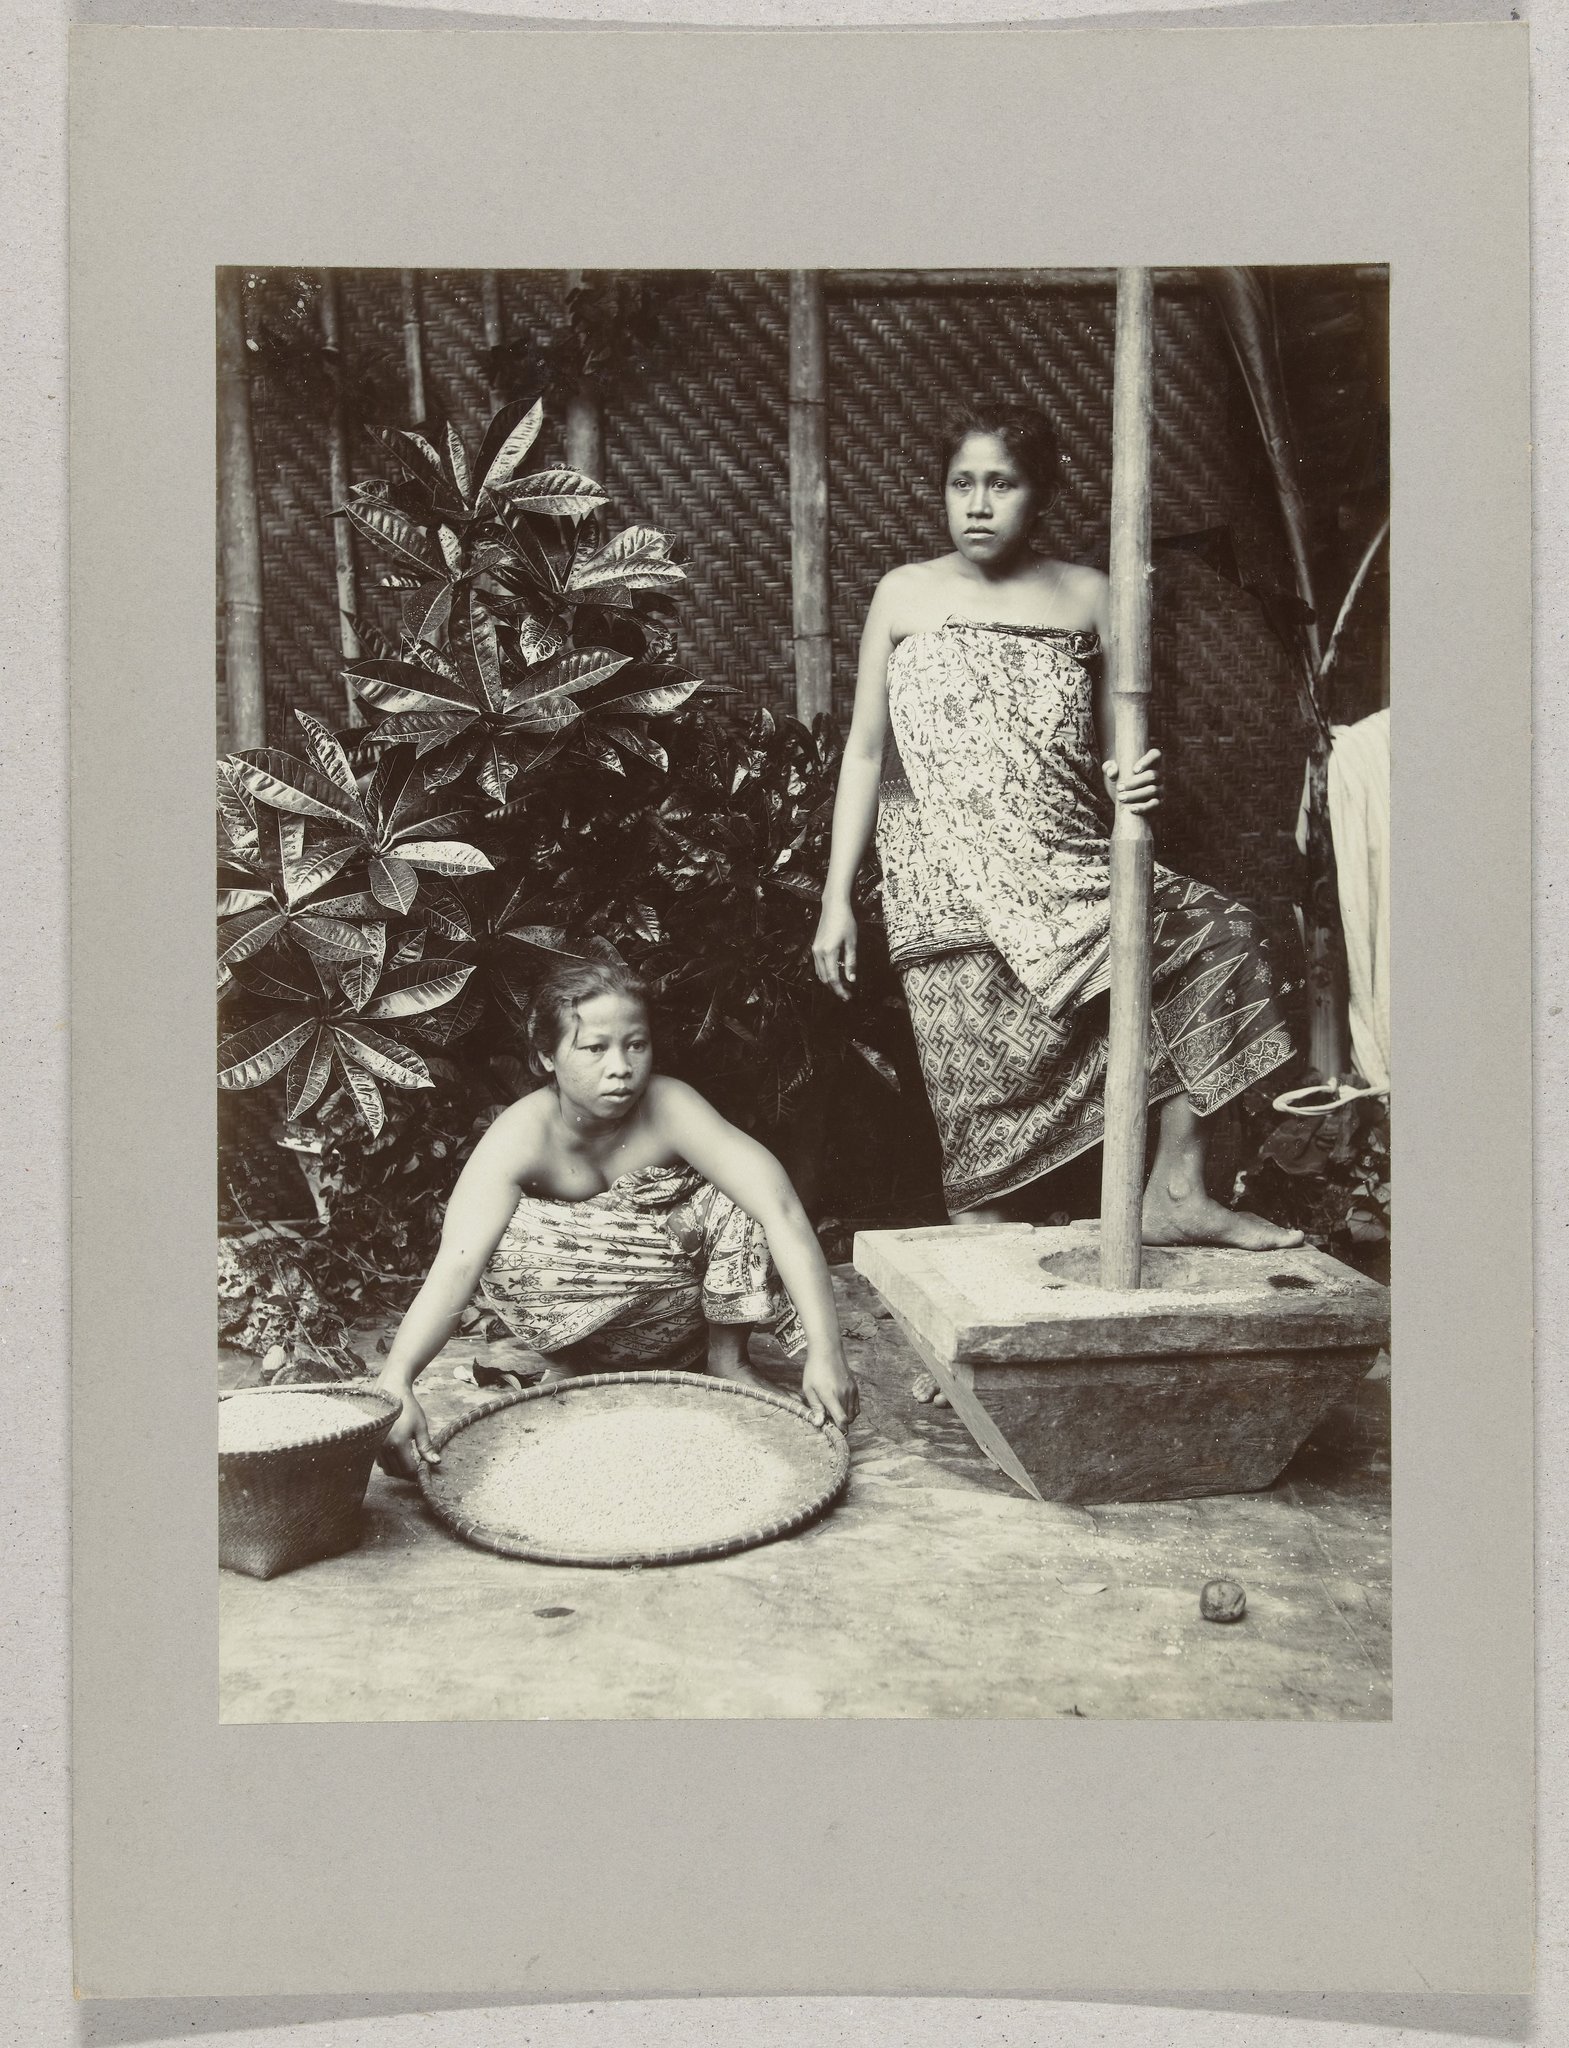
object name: photograph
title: Studioportret van een twee meisjes tijdens het zeven en stampen van rijst in Nederlands-Indië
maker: Anonymous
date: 1895-1915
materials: cardboard, paper, photographic support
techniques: gelatin silver print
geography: dutch east indies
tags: indonesia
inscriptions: number: ‘32’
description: Portret van een twee meisjes bezig met het zeven en stampen van rijst (?), gemaakt in een studio, Nederlands-Indië